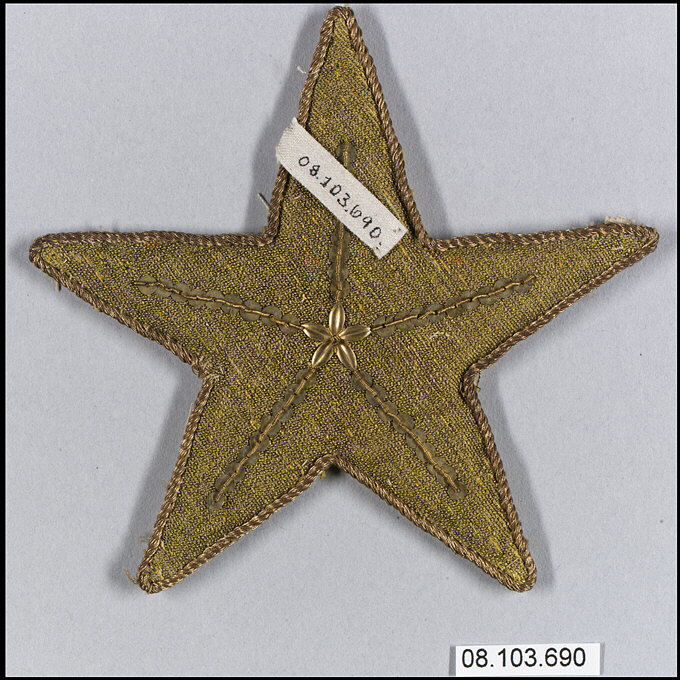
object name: ornament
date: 1801-1833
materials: metal, metal thread